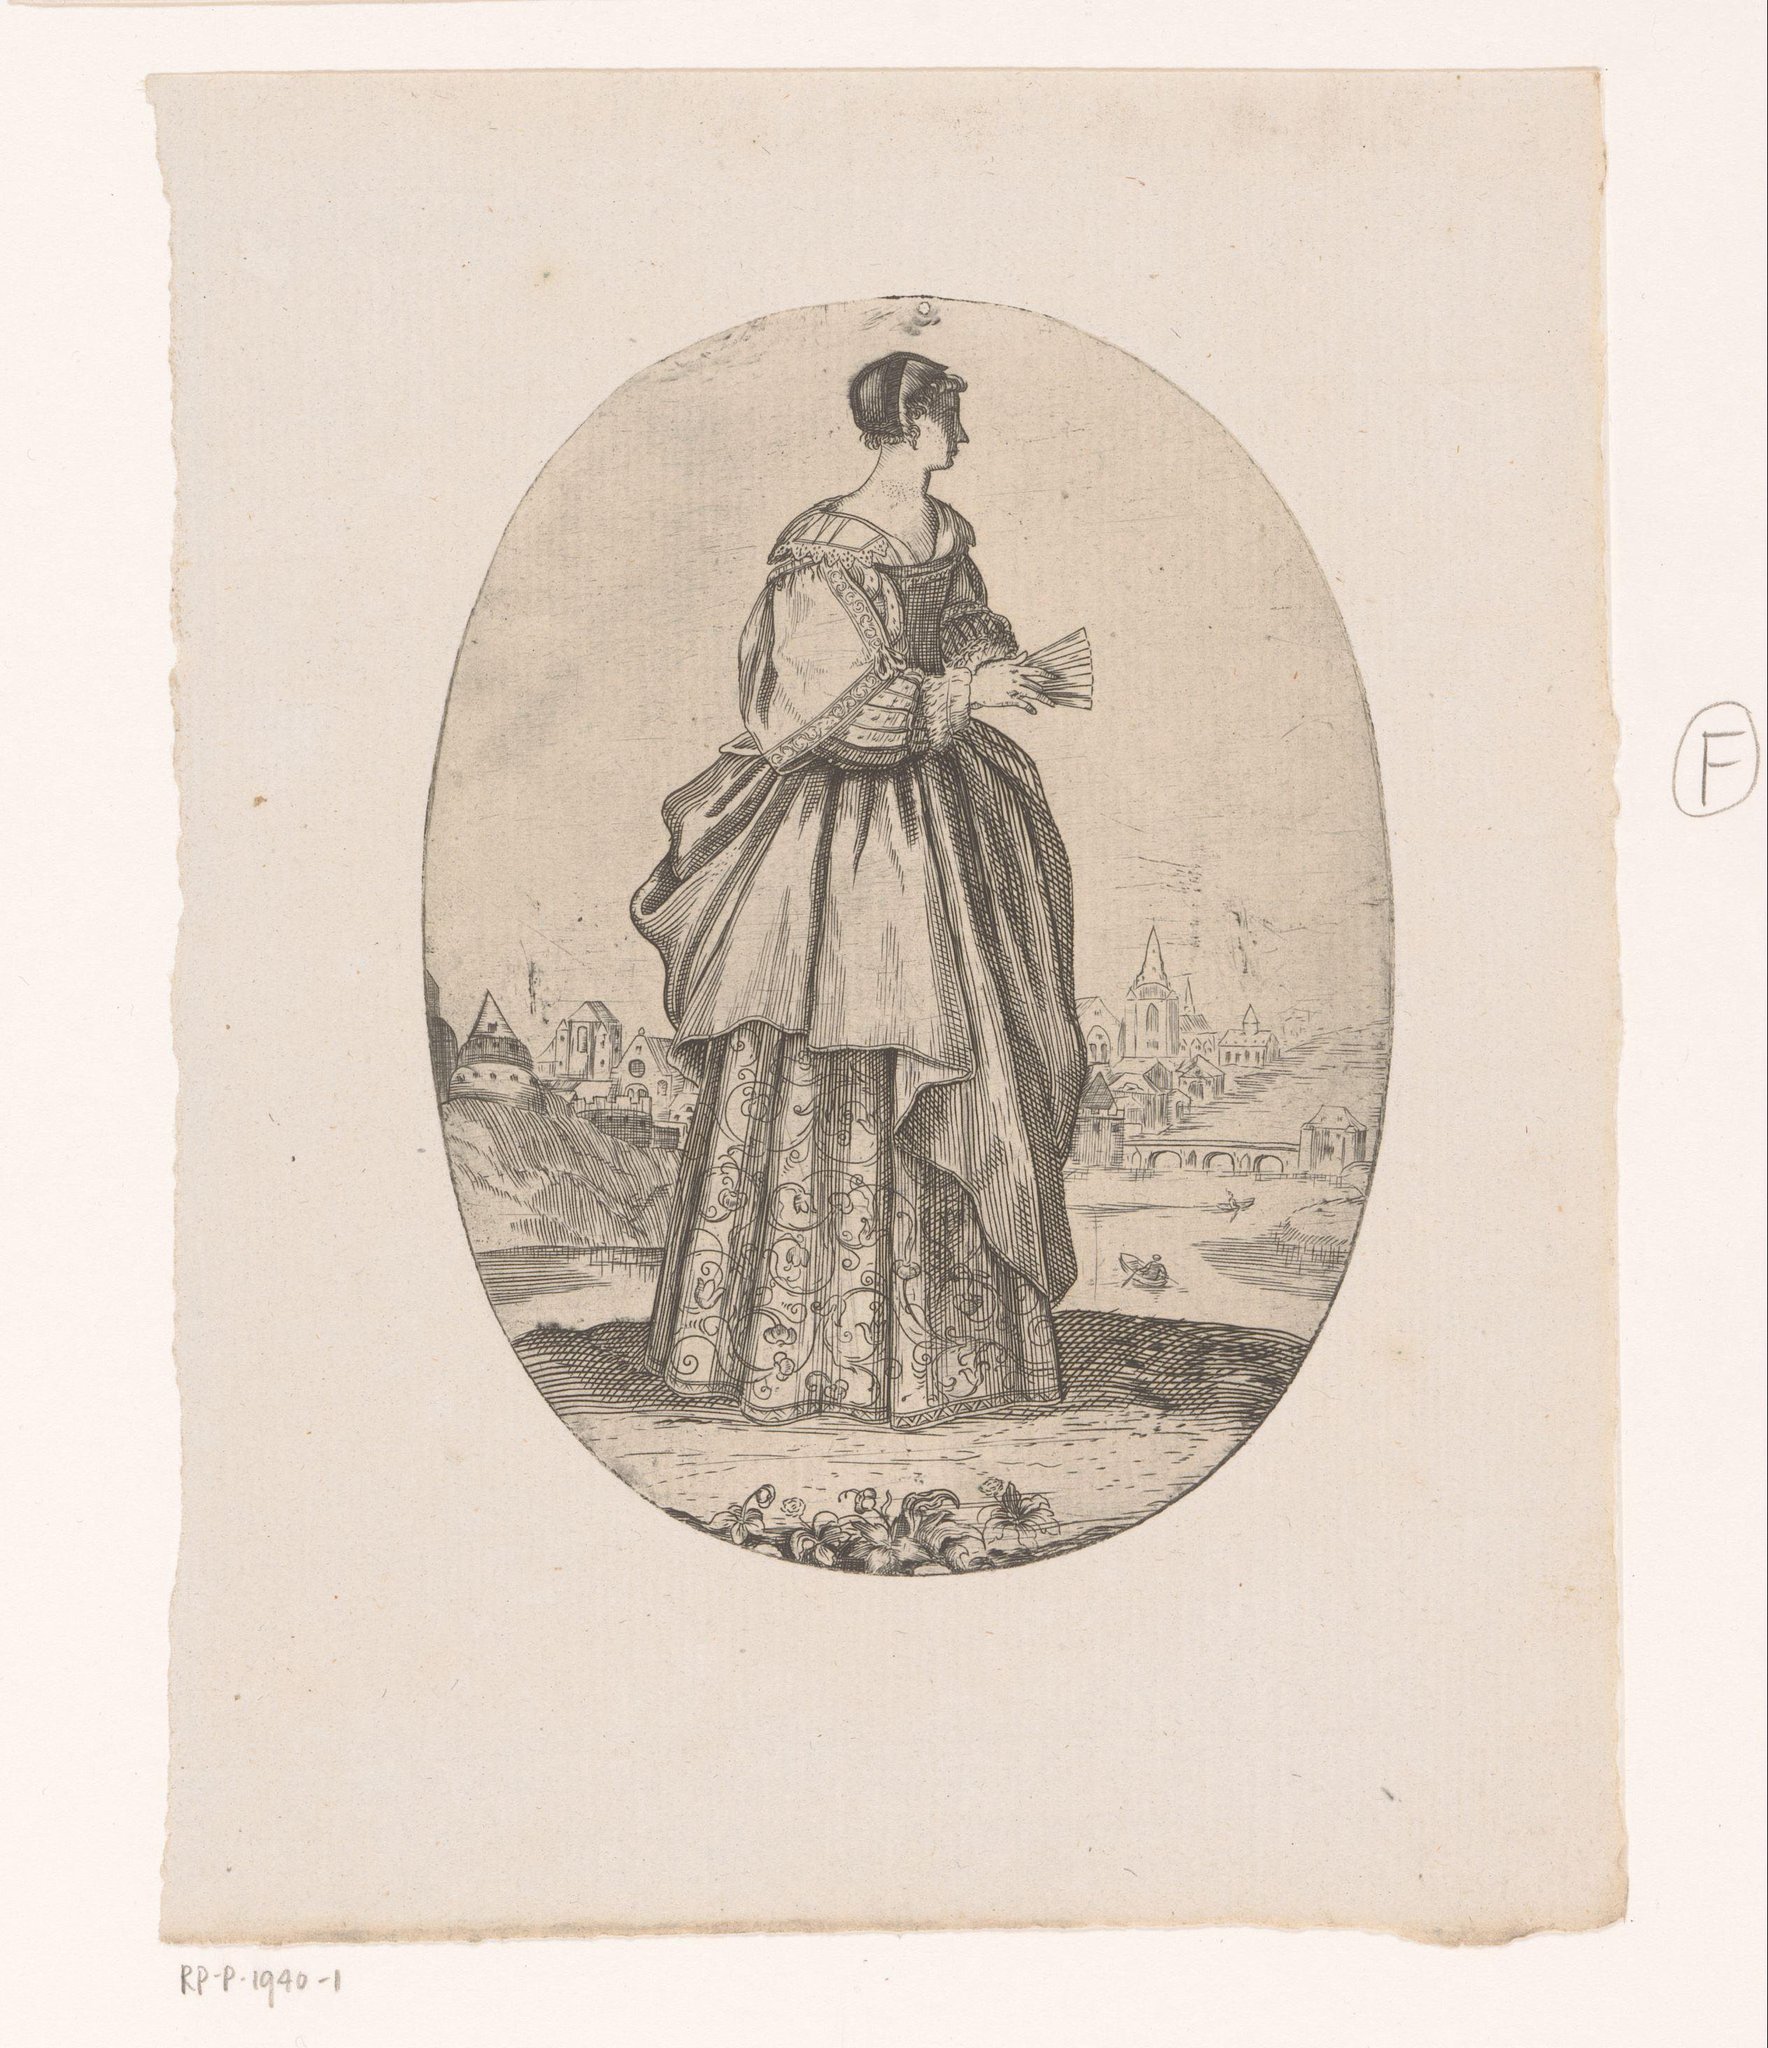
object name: print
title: Dame gekleed volgens de mode van circa 1620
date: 1625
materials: paper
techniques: engraving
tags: clothes, costume (+ women's clothes)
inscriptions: collector's mark: Lugt 2228, : ‘moderne afdruk van een Anonieme Fransche kopergravure van ± 1620, waarvan de koperen plaat in het bezit is van Jhr. B.W.F. van Riemsdijk te Amsterdam. Geschenk van Jhr. B.W.F. van Riemsdijk’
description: Kostuumprent: Vrouw met mutsje op het haar, staande in een landschap met waaier in de hand, naar rechts. Op de achtergrond een rivier en een stad. In ovaal.